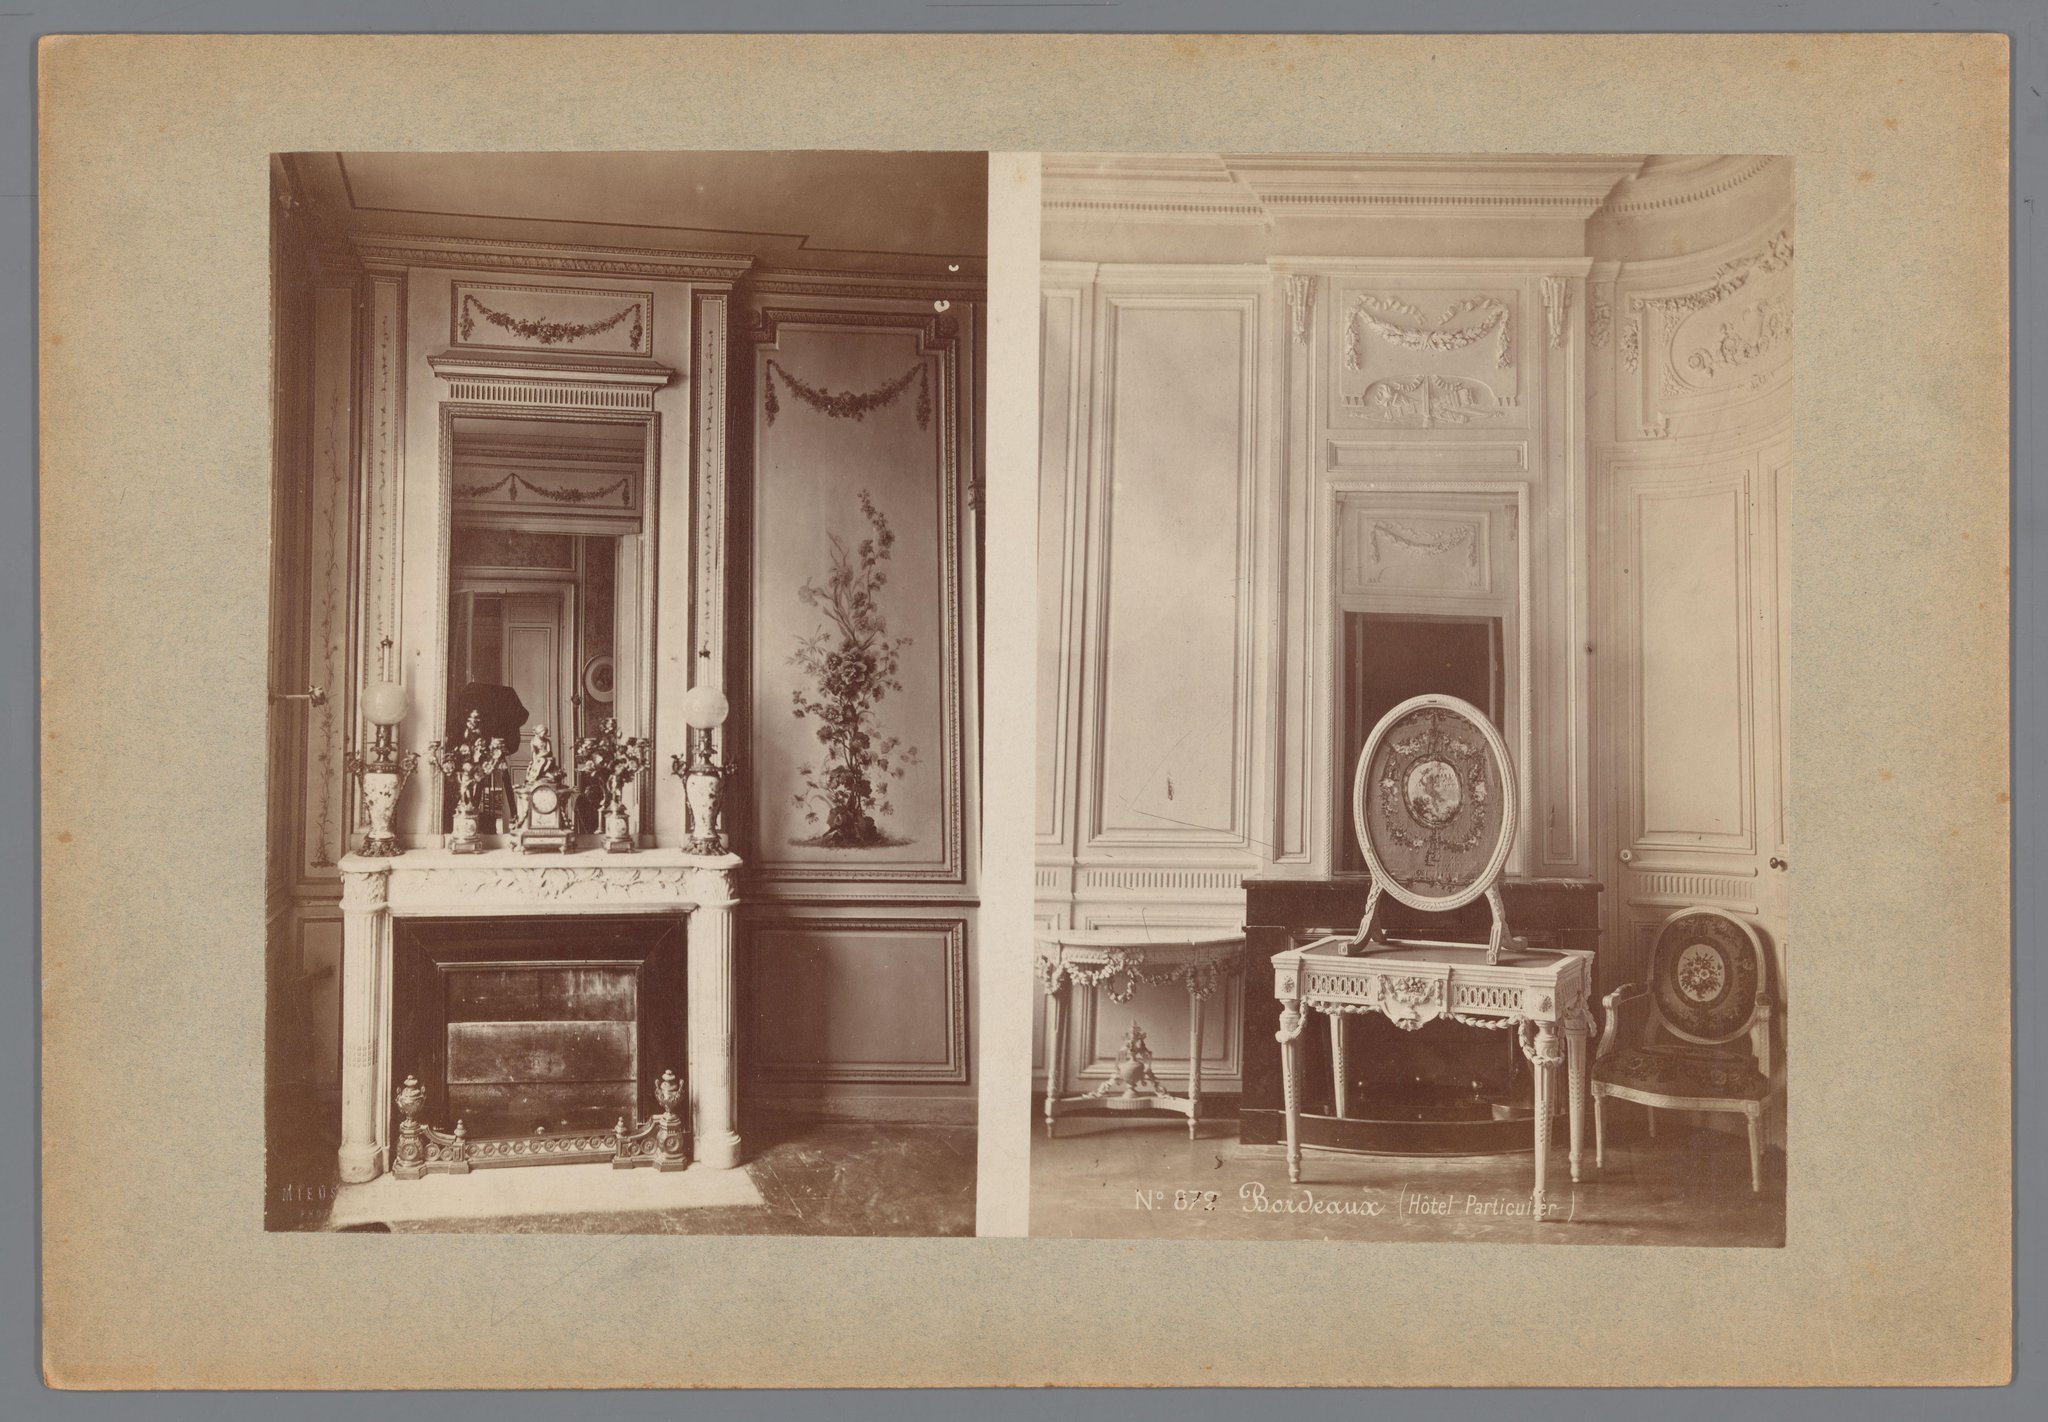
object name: photograph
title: Twee interieurs van een stadspaleis te Bordeaux met een schouw en een spiegel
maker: séraphin-médéric mieusement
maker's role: fotograaf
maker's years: 1840-1905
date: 1875-1900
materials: cardboard, photographic support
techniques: albumen print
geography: bordeaux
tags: mirror, open hearth, fire-place, interior ~ representation of a building, hôtel, i.e. small palace in city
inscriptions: name: ‘KUNSTBOEKHANDEL J. A. G. DE LEUR PHOTOGRAAF-UITGEVER Huigenspark, 40b. DEN HAAG.’, number: ‘872’, inscription: ‘stijlkast pl 13’, inscription: ‘MONUMENTS HISTORIQUES’, name: ‘MIEUSEMENT PHOTOGRAPHE’, collector's mark: Lugt 3937